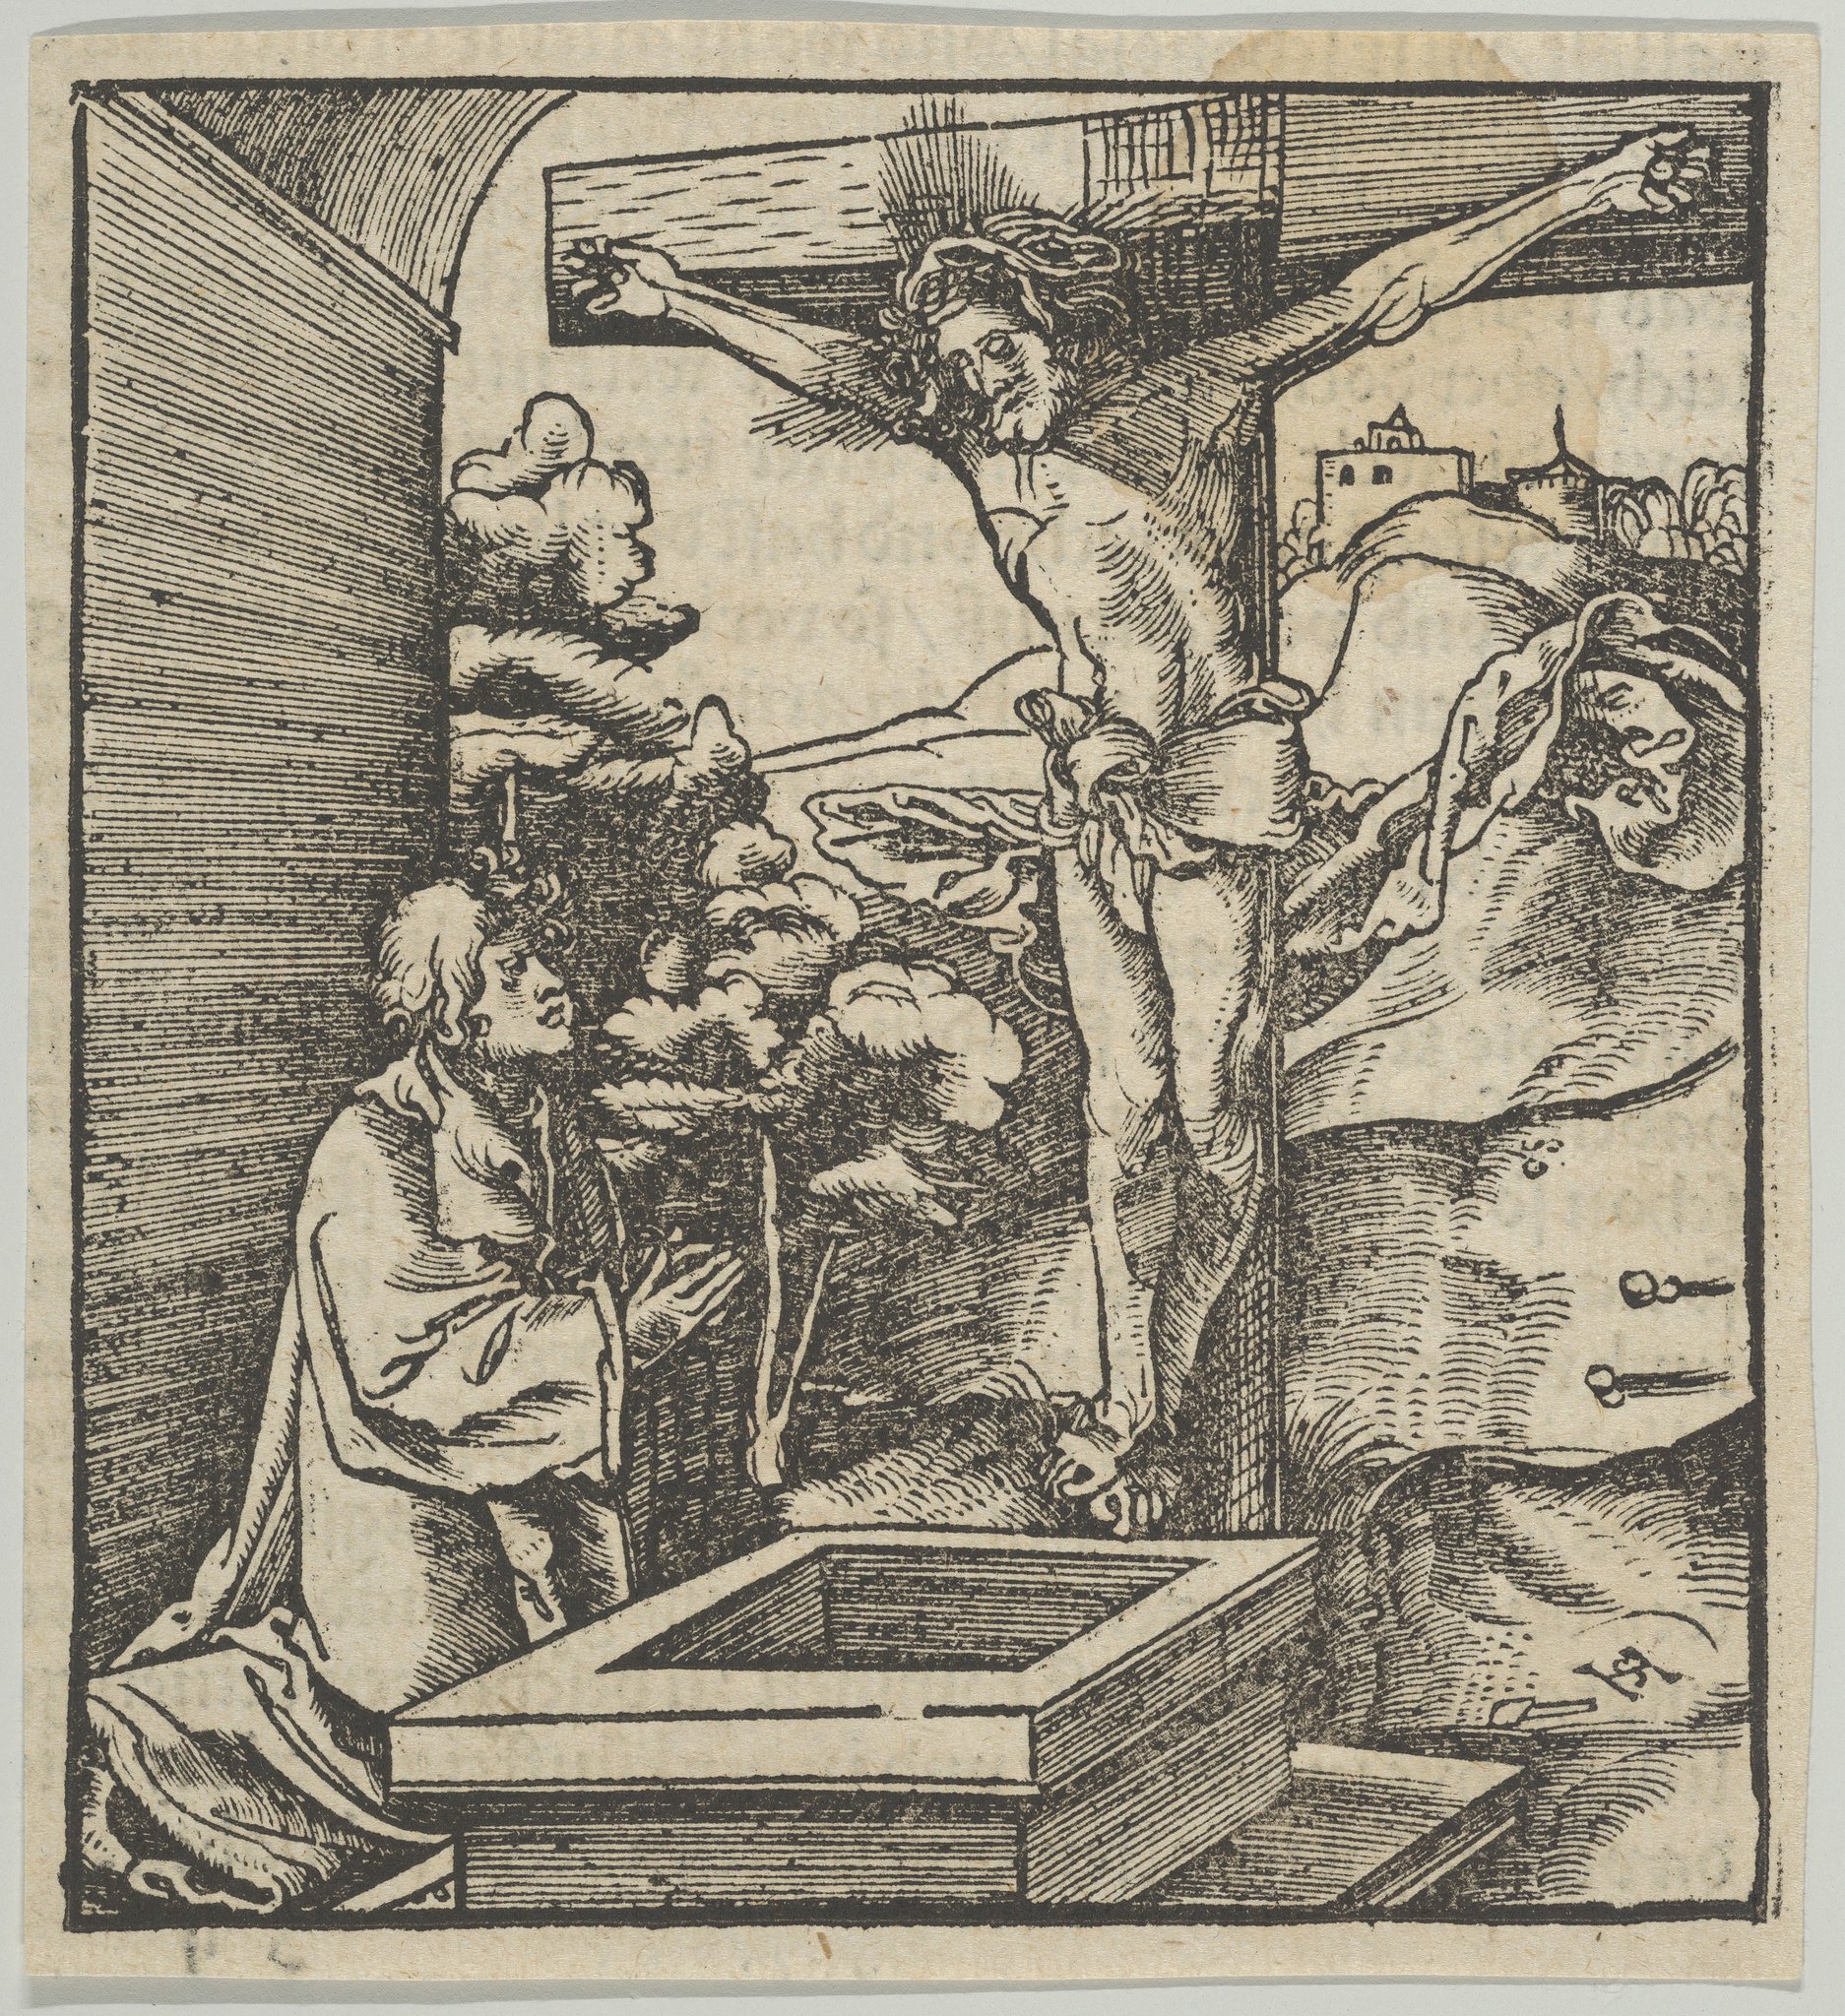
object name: print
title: A Man Praying before a Crucifix, from Hymmelwagen auff dem, wer wol lebt...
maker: hans schäufelein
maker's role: artist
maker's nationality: german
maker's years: 1480-1540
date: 1517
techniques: woodcut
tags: men,christ,cross,crucifixion,praying